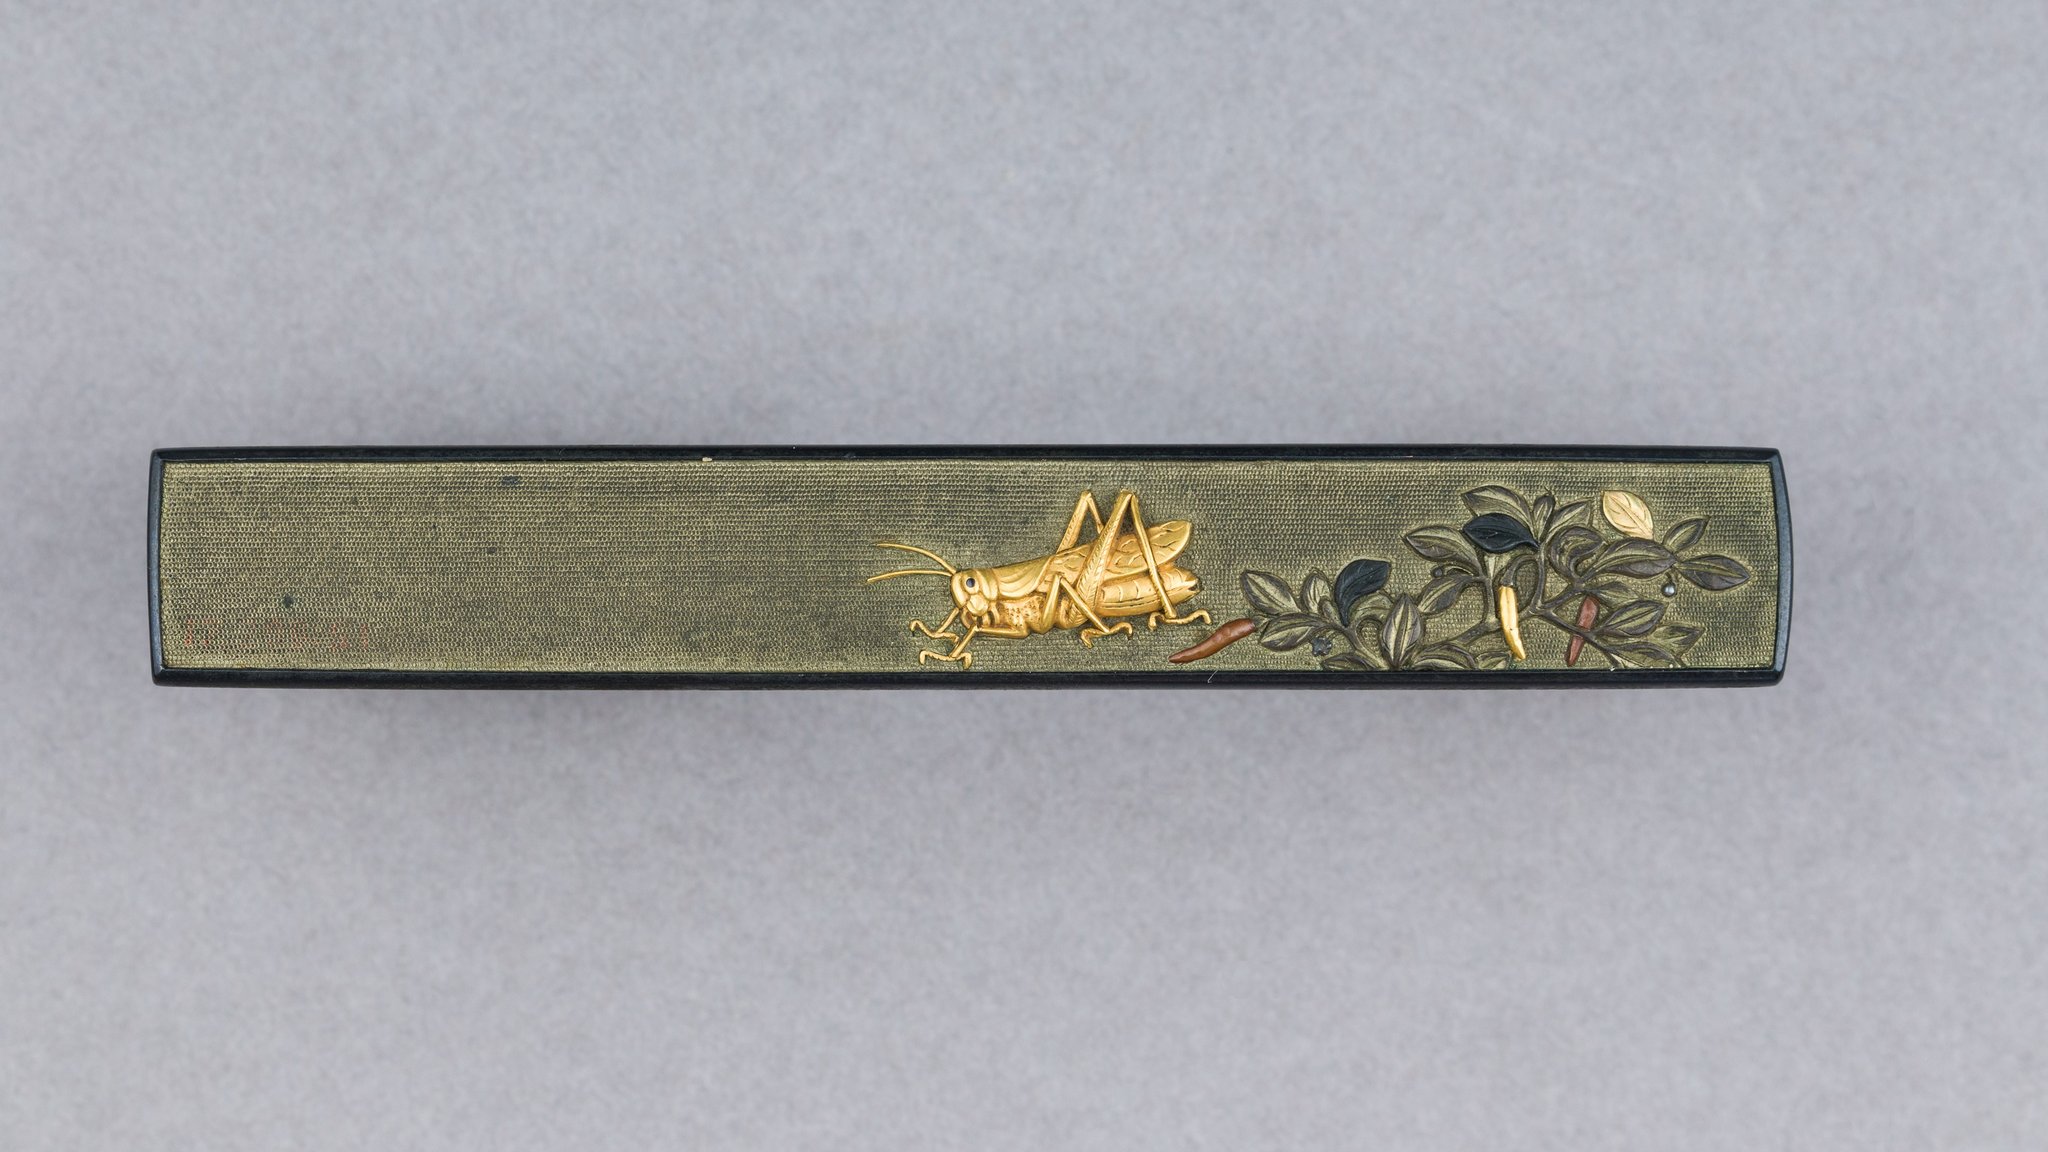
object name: knife handle kozuka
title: Knife Handle (Kozuka)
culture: japanese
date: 1801-1900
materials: copper, gold alloy, silver alloy, gold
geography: japan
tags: insects